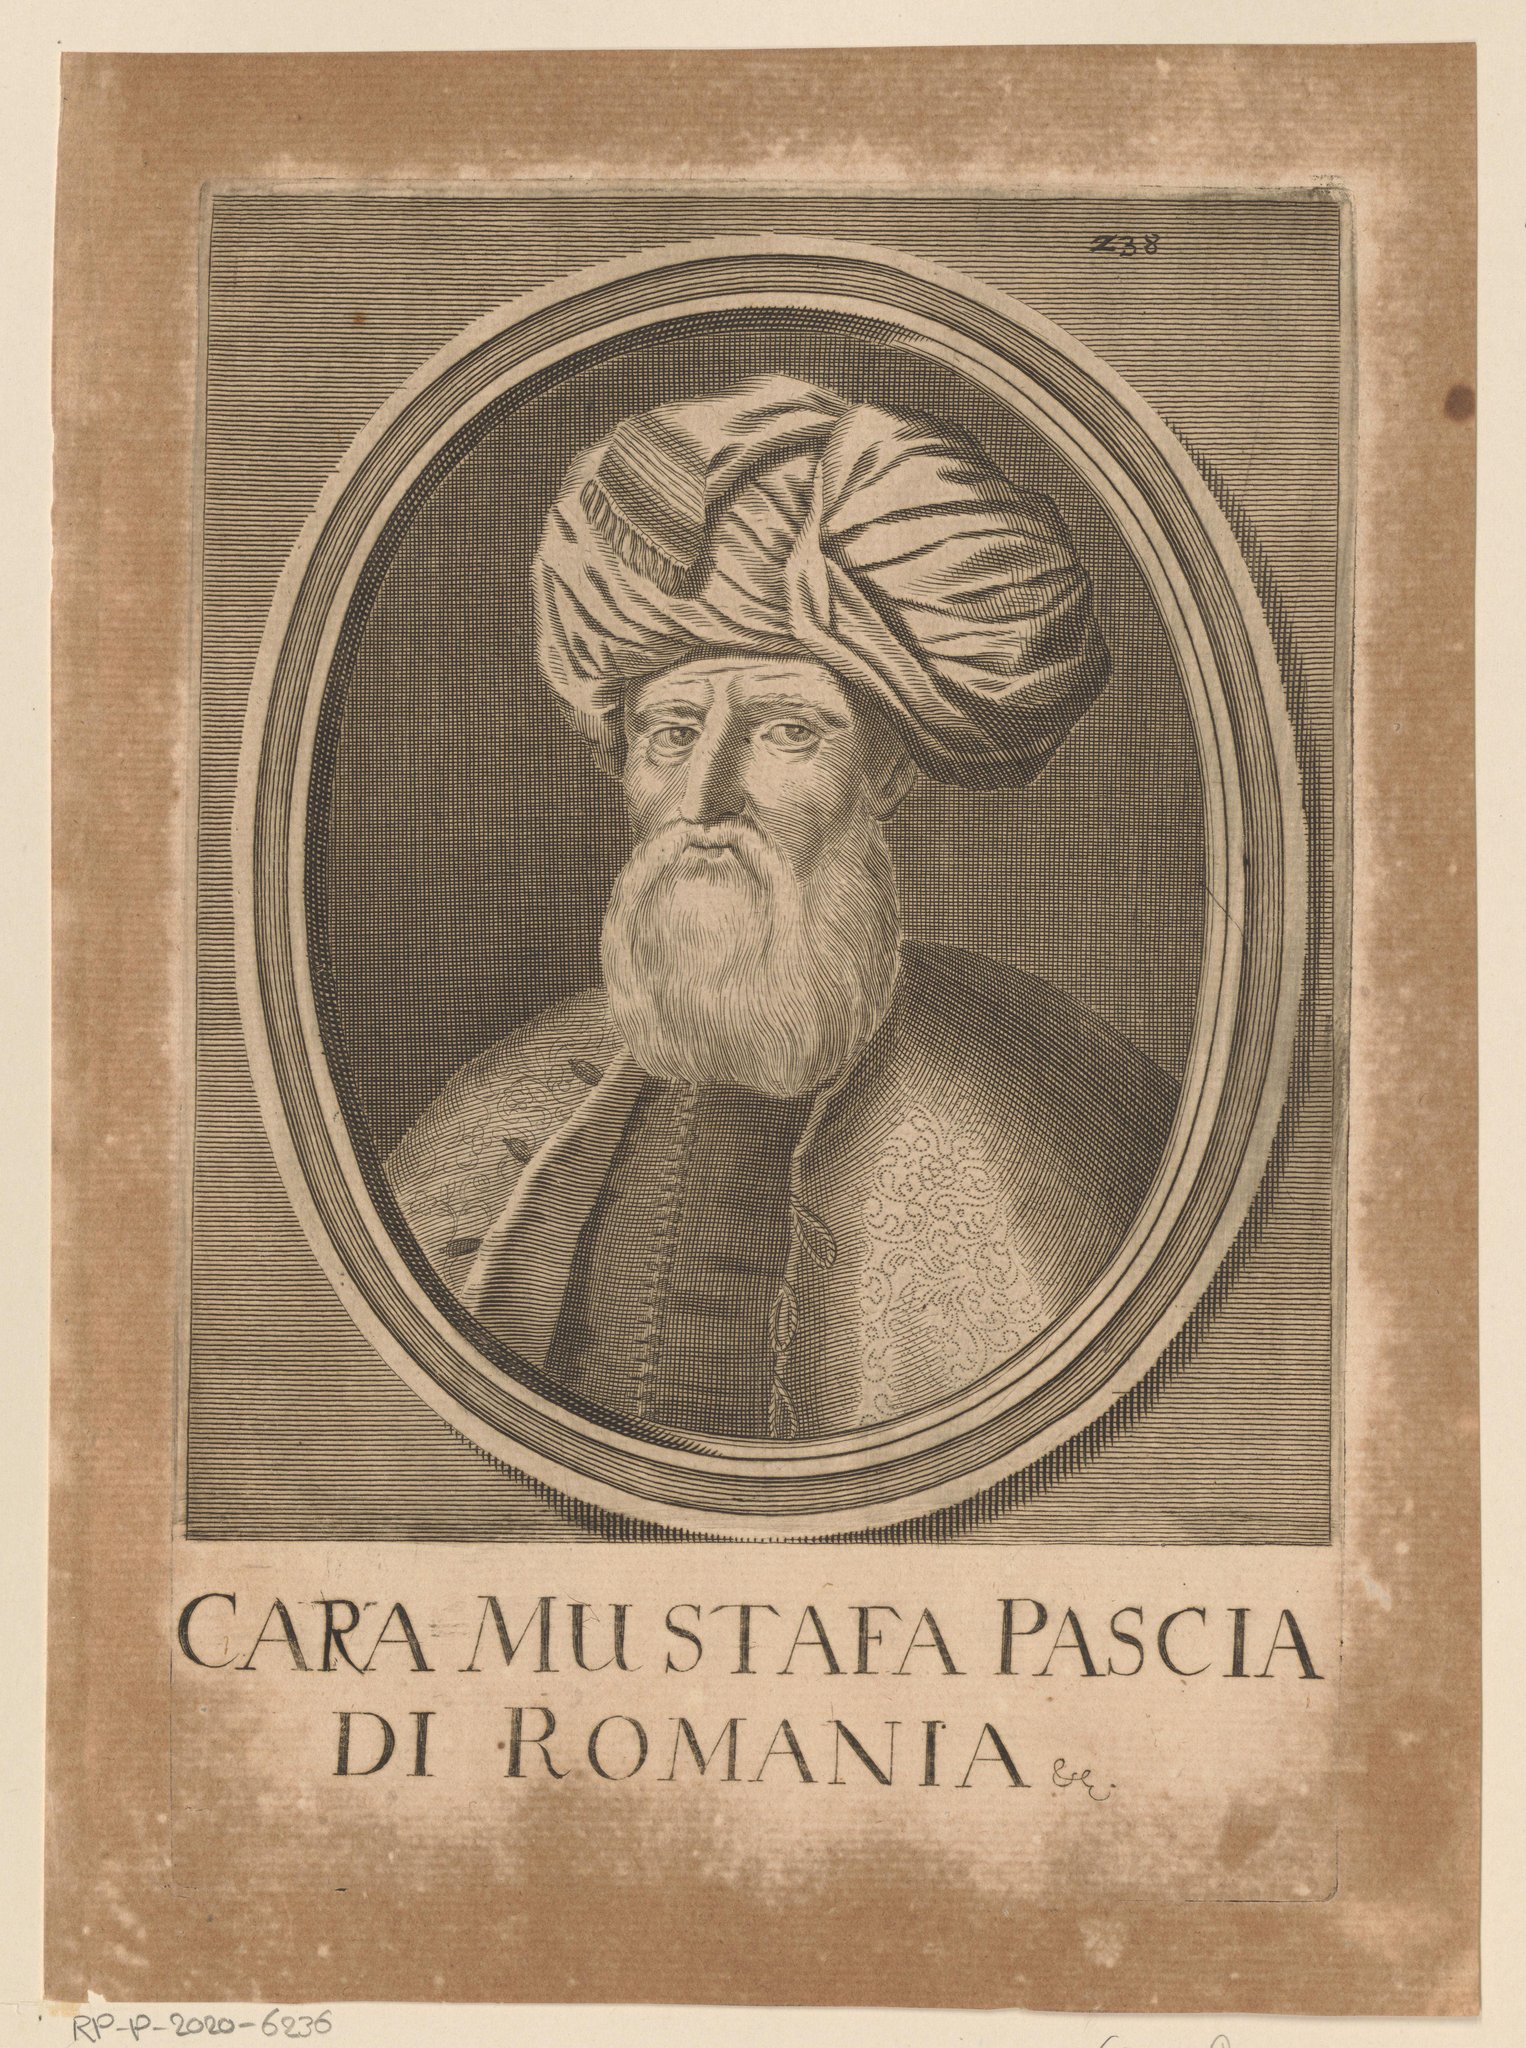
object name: print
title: Portret van Kara Mustafa Pasja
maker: Anonymous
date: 1674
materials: paper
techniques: engraving, etching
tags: historical persons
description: Prent mogelijk uit: Priorato, Galeazzo Gualdo. Historia di Leopoldo Cesare (...). Wenen: Giovanni Battista Hacque, 1674, dl. 3.